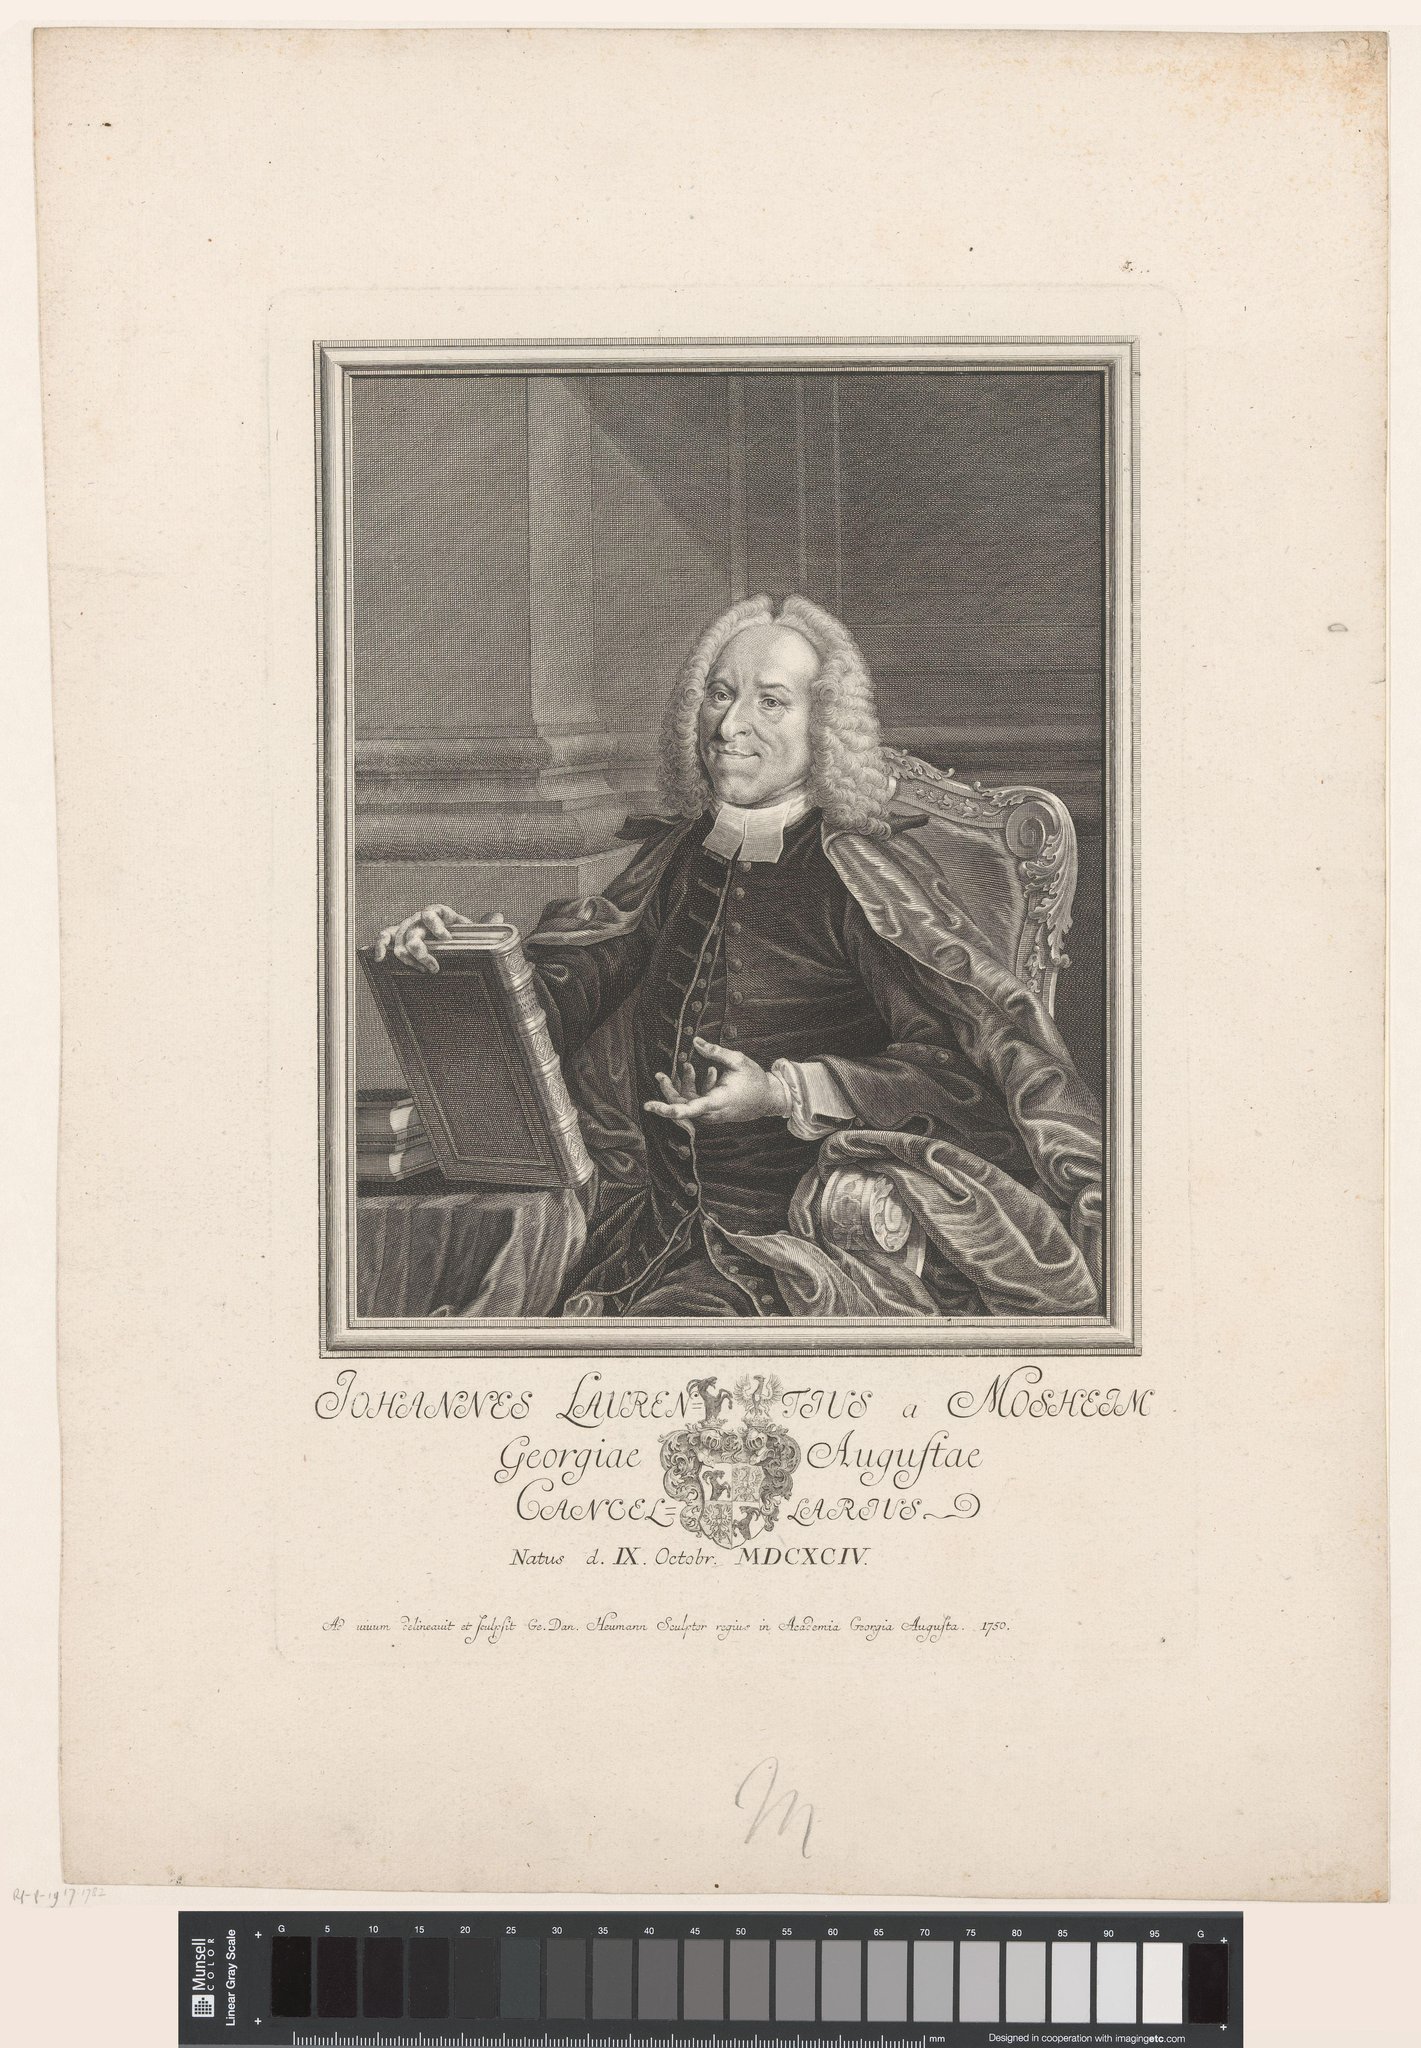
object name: print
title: Portret van Johann Lorenz von Mosheim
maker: georg daniel heumann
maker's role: print maker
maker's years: 1691-1759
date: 1750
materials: paper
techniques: engraving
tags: historical persons, armorial bearing, heraldry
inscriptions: collector's mark: Lugt 2228, collector's mark: Lugt 1496c